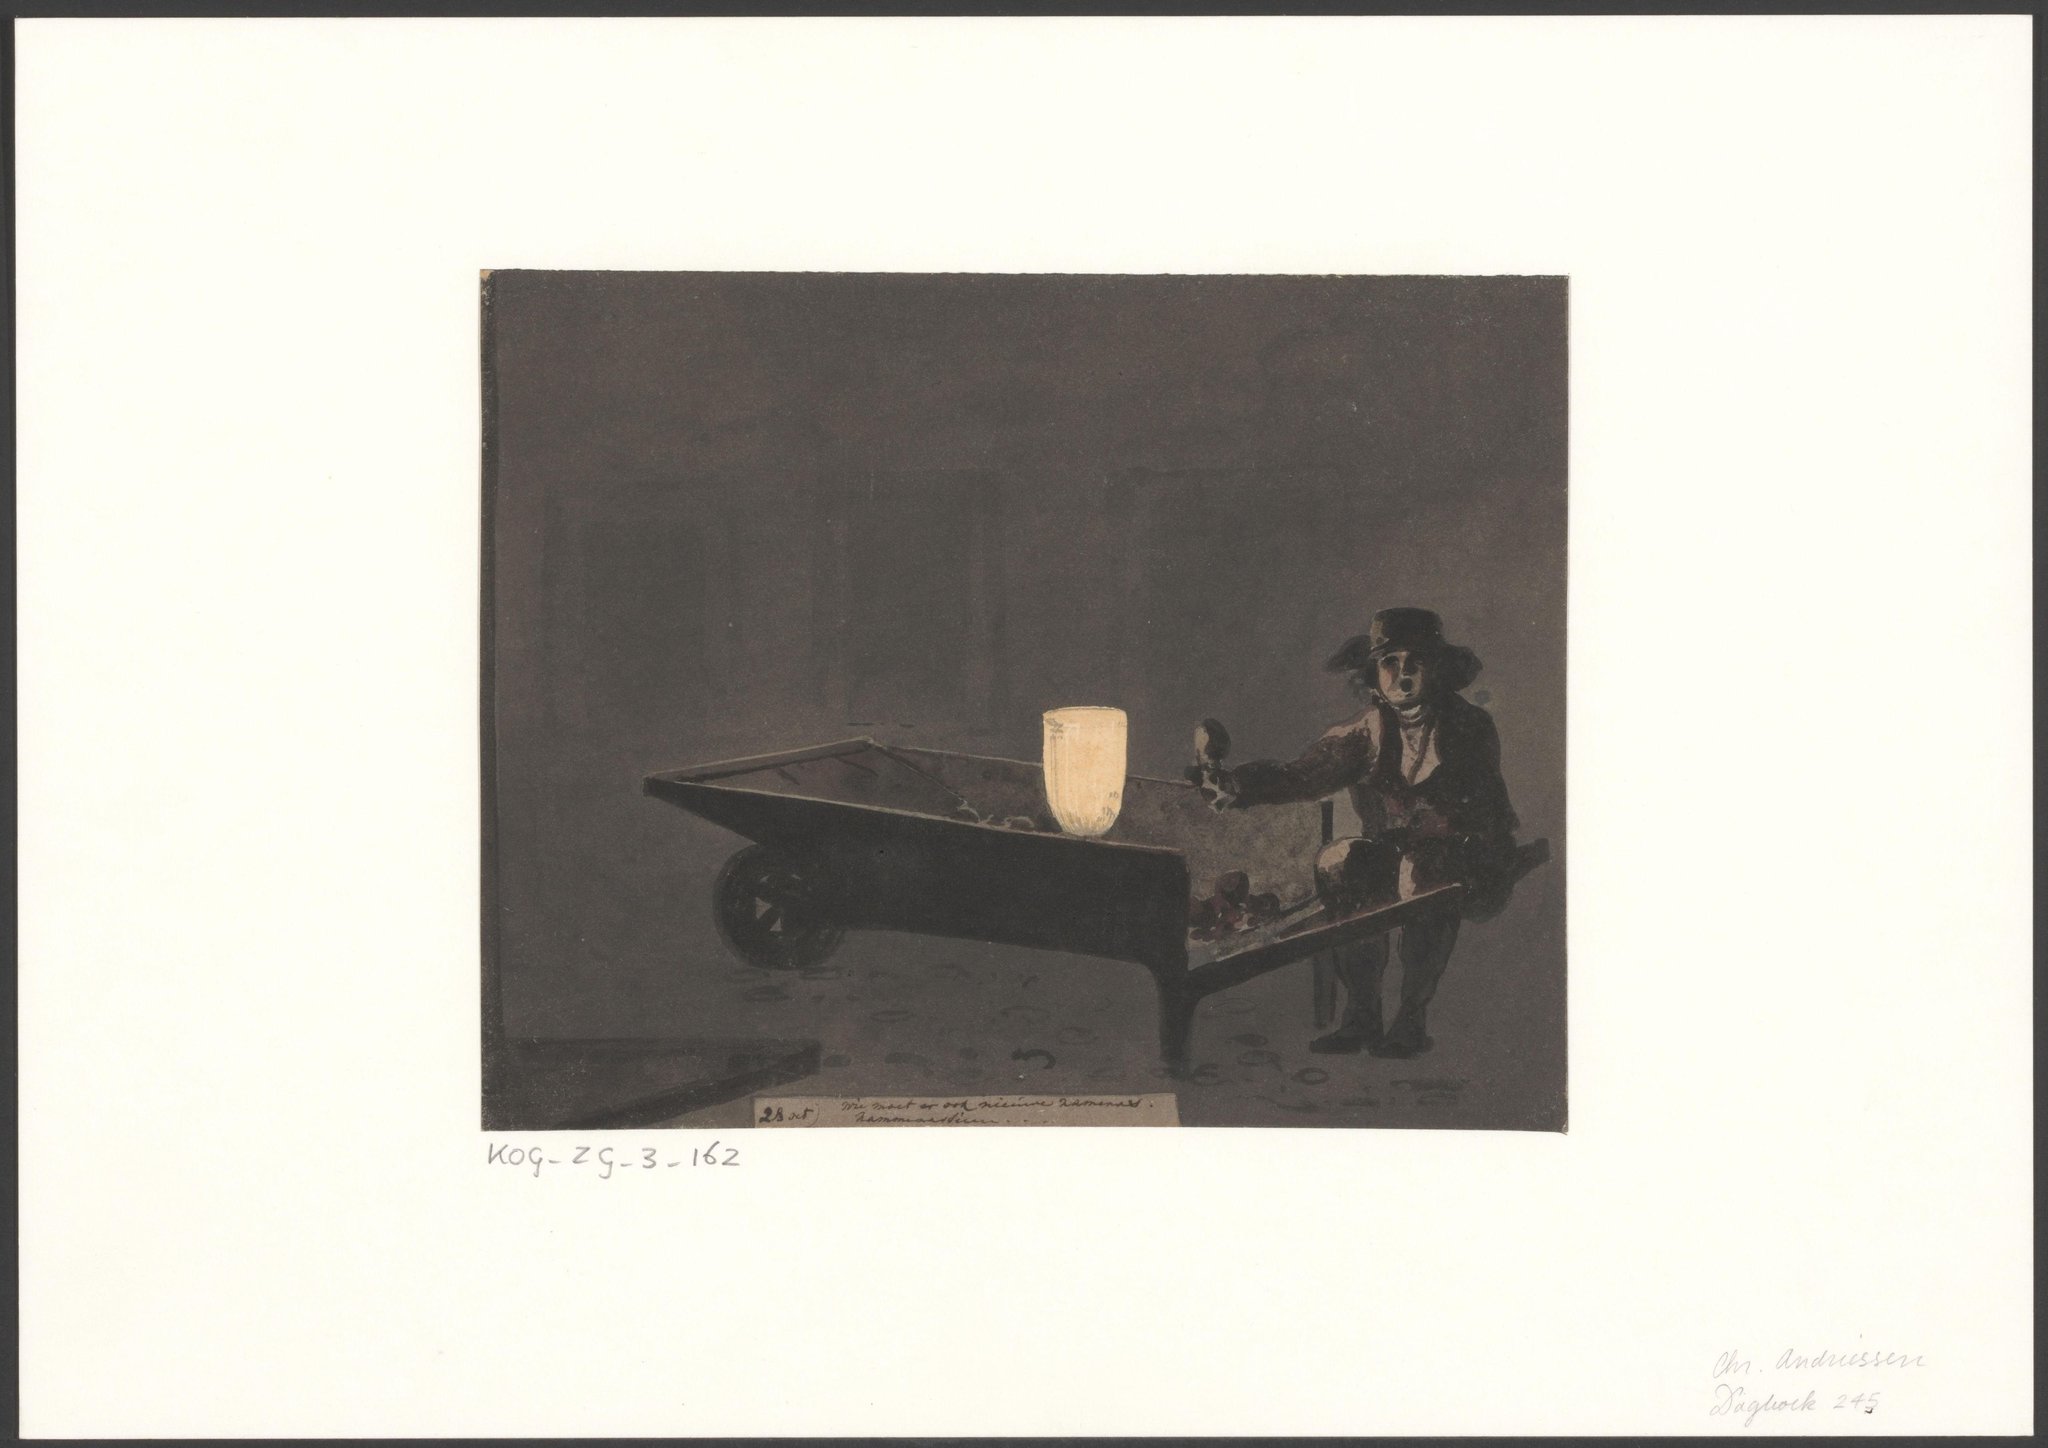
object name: drawing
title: Straatventer die ramenassen uit zijn kruiwagen verkoopt in de avond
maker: christiaan andriessen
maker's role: draughtsman, print maker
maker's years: 1775-1846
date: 1805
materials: ink, paper, pencil, watercolor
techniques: brush, pen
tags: persons engaged in trade and commerce, (non-fruit) products of plants or trees: radish, amsterdam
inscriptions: inscription: ‘28 oct Wie moet er ook nieuwe ramenas rammenassieren’, signature: ‘J Andriessen’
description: Straatventer die ramenassen uit zijn kruiwagen verkoopt in de avond. Hij heeft een licht op zijn kar gemonteerd.